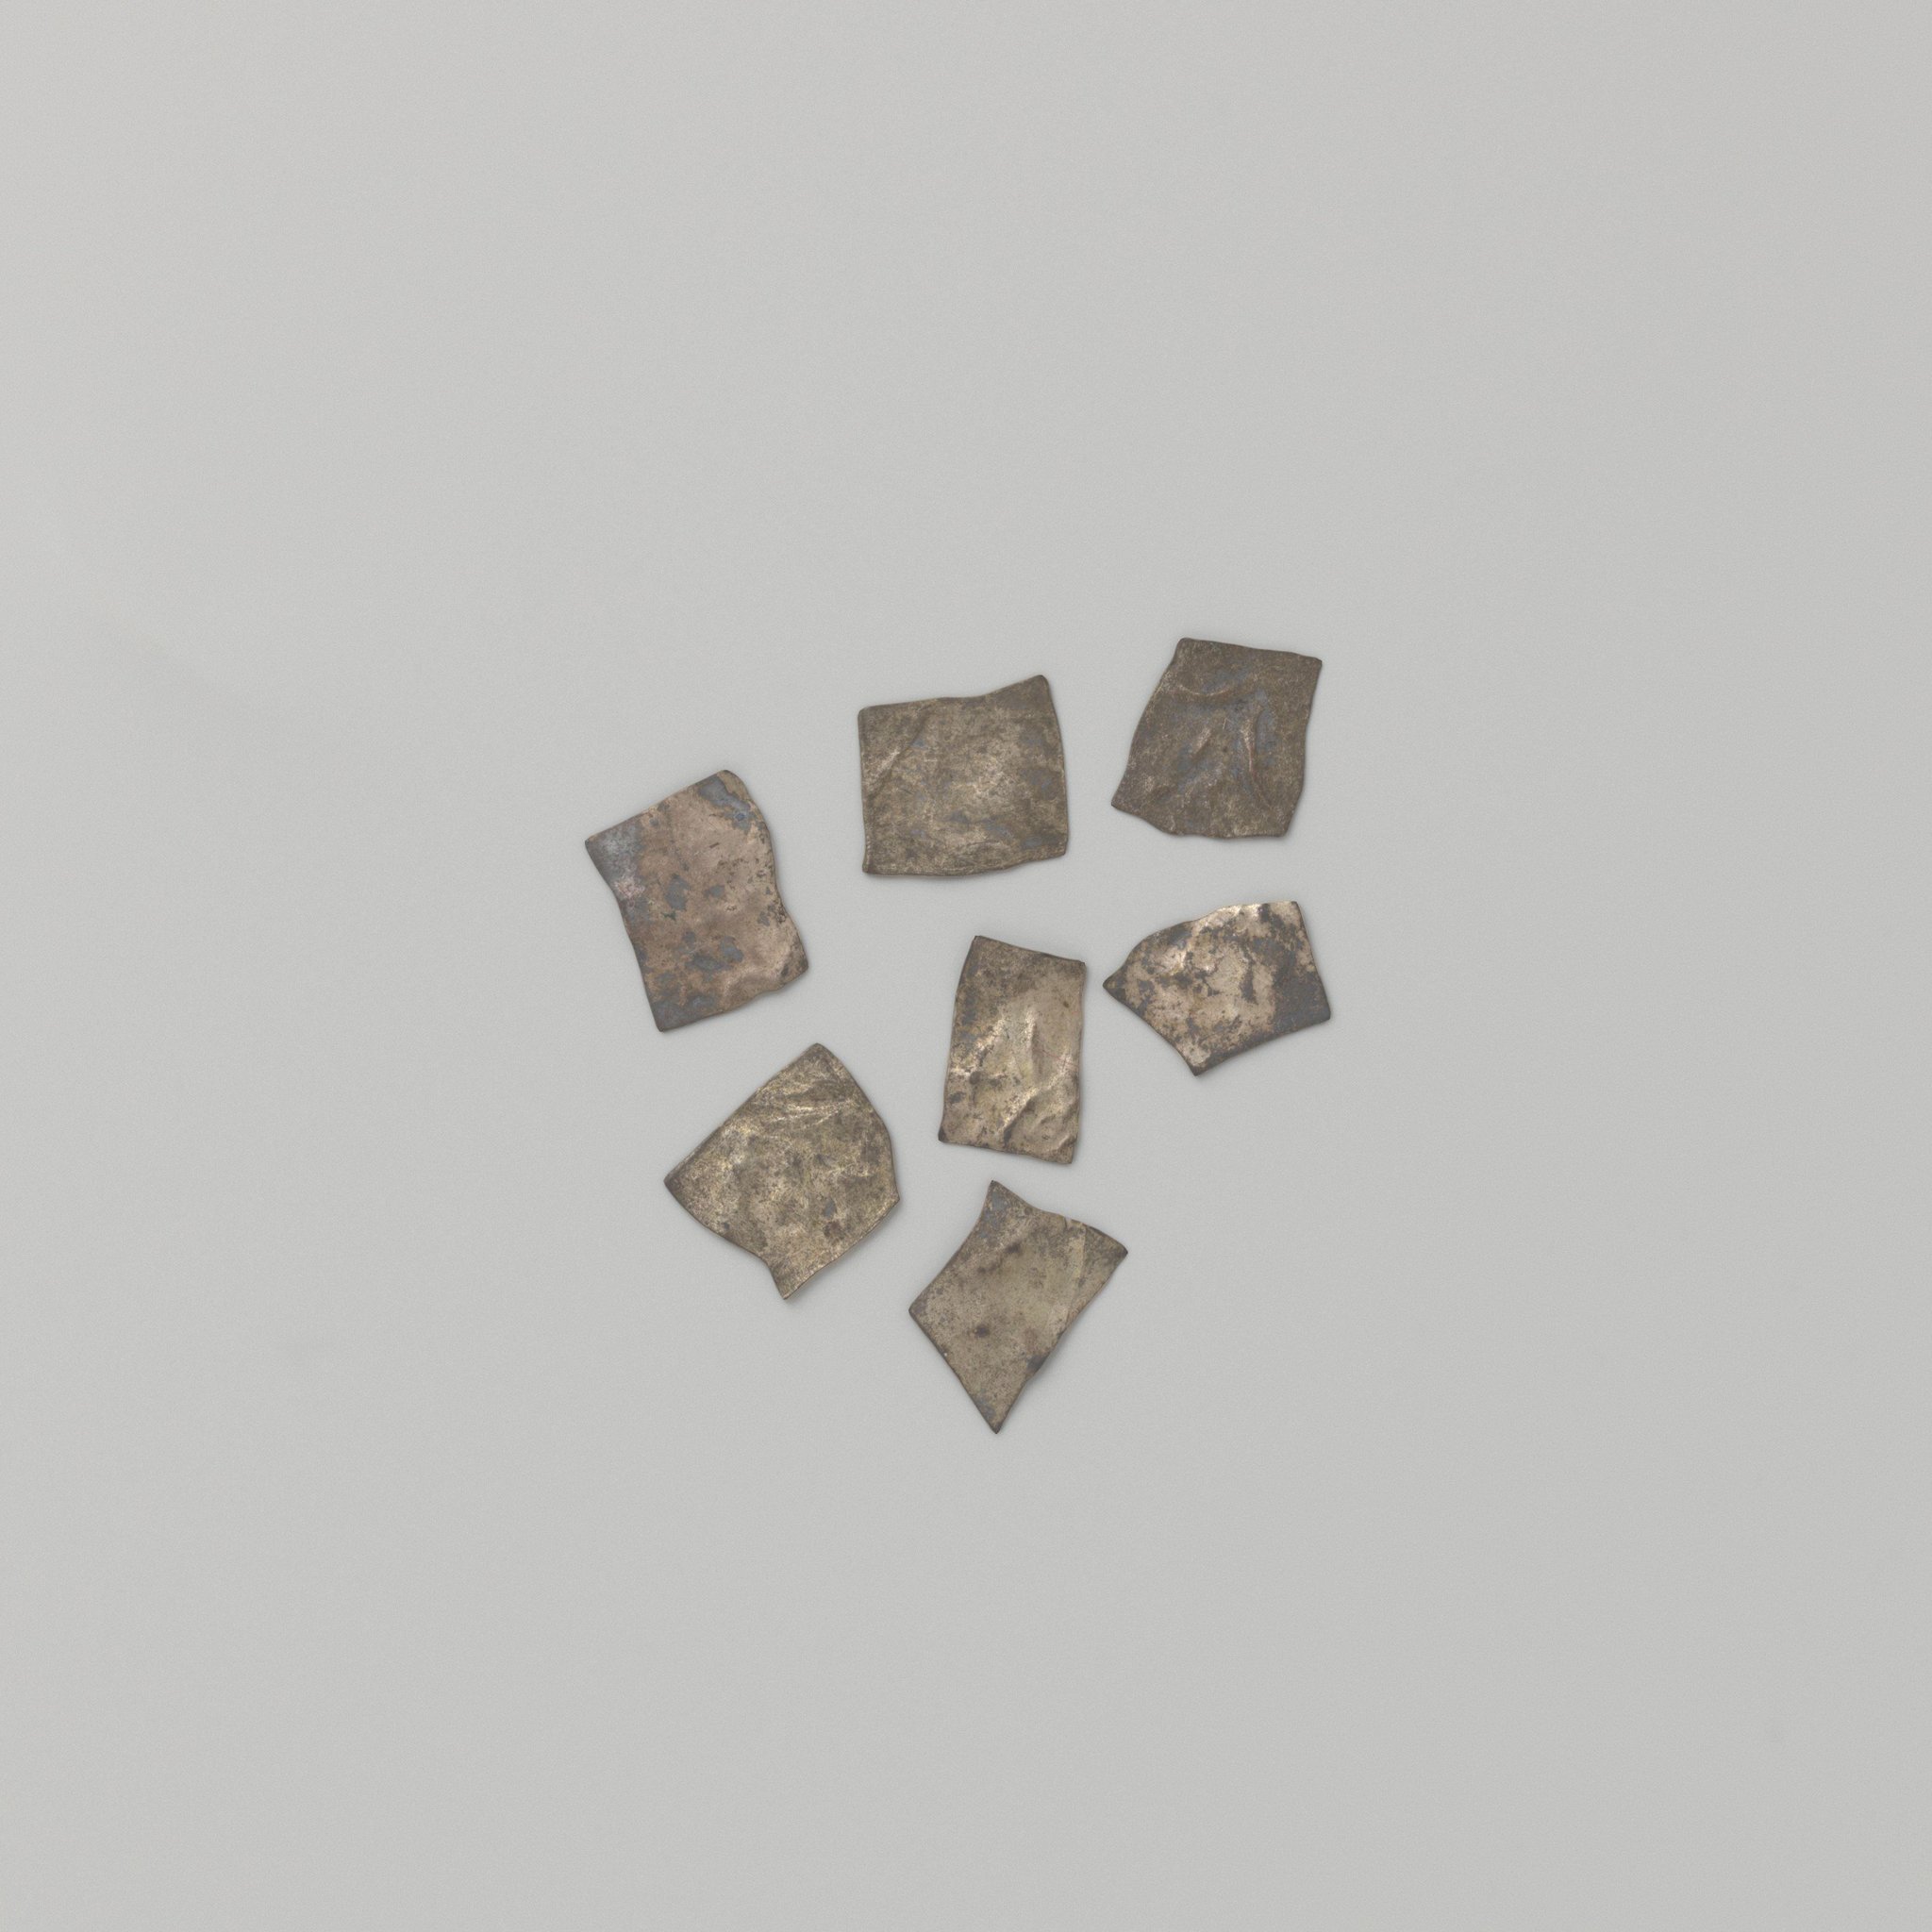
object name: coin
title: Dubbele dam [?] uit Nepal, bestaande uit 7 vierkante stukjes bladzilver van gemiddeld 7/100 gram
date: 1700-1900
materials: silver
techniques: striking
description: Zeven zilveren vierkante stukjes bladzilver, waarvan sommige met letters bestempeld, gebruikt als munt.